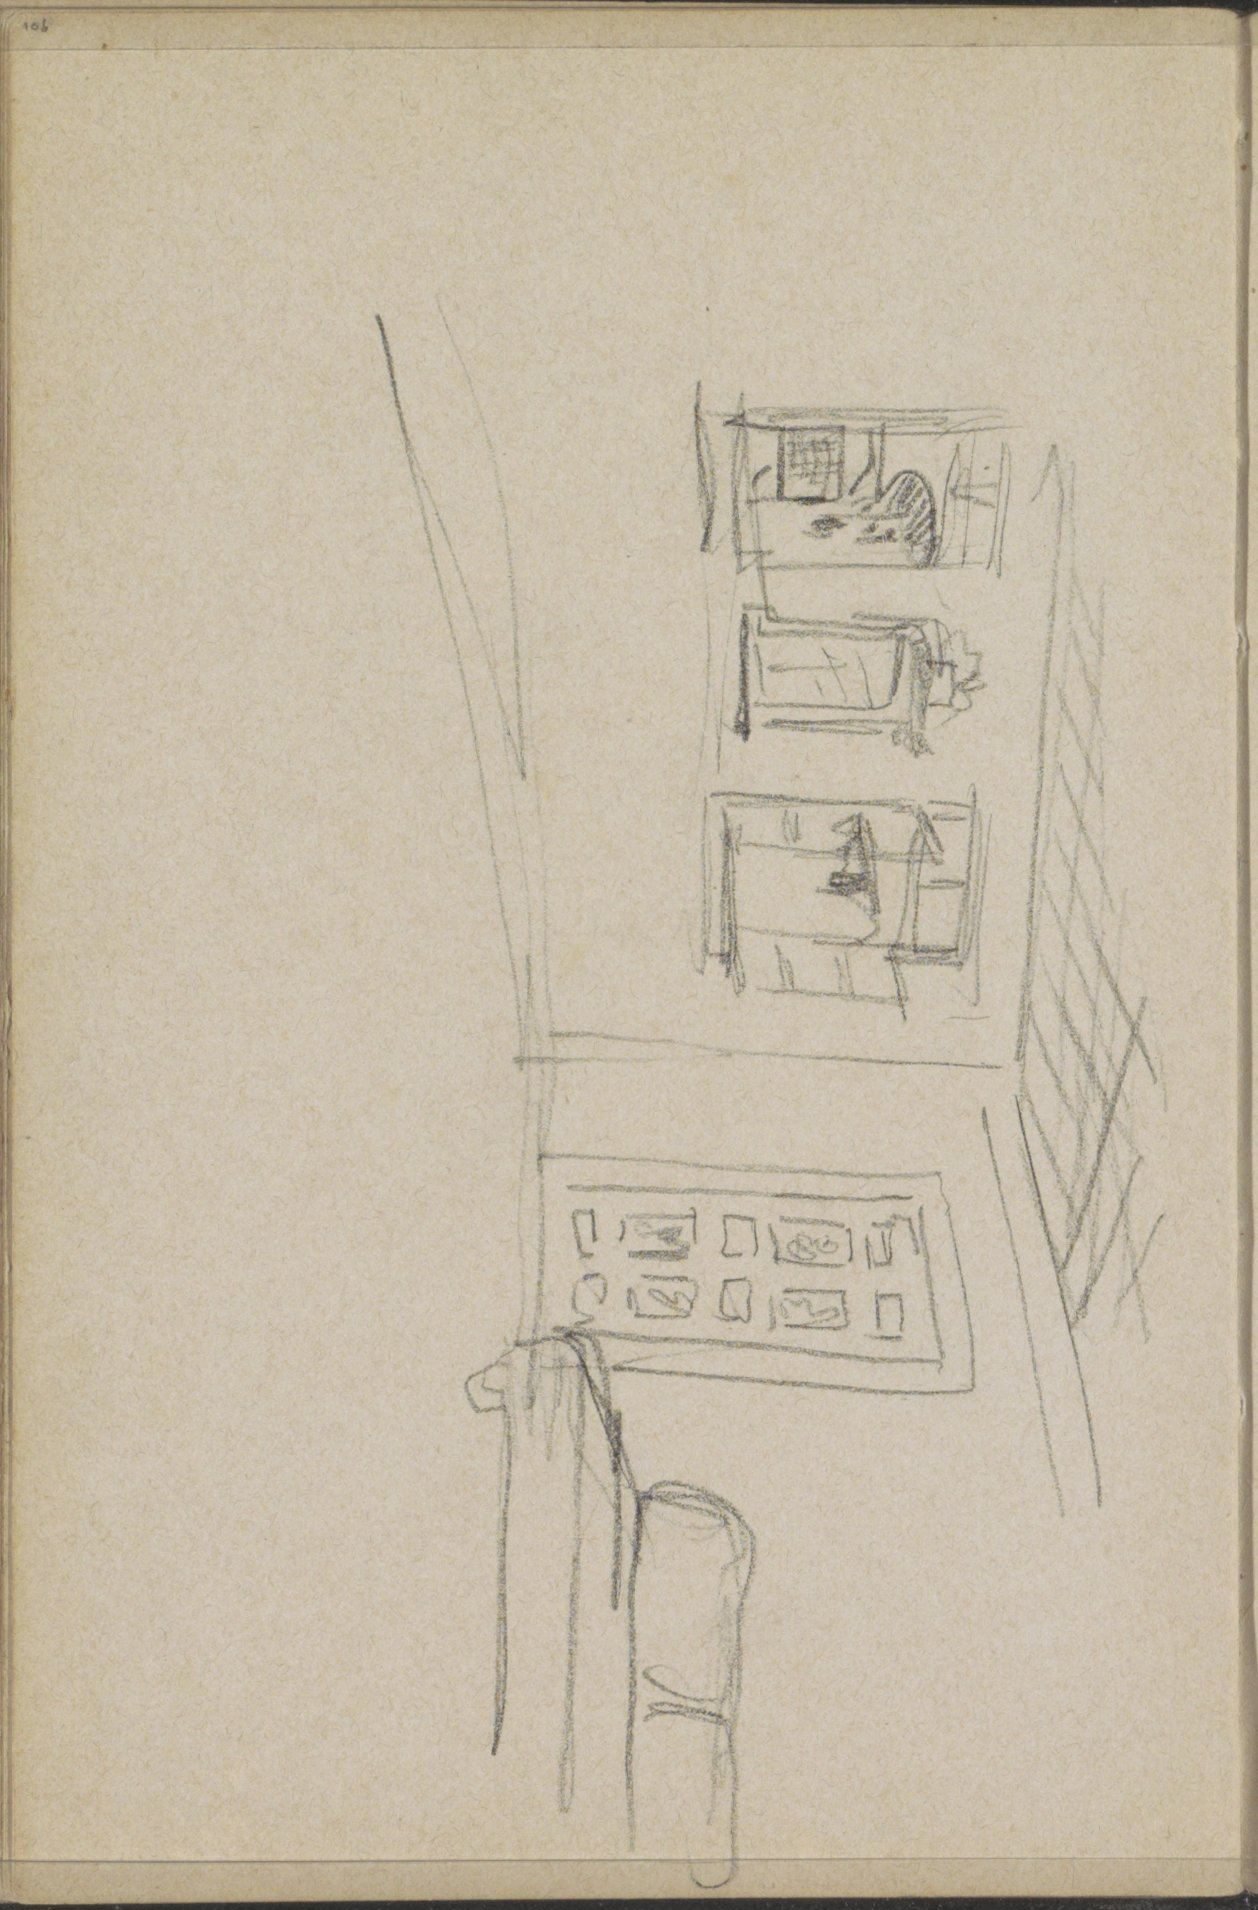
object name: sketchbook leaf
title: Interieur van het Bachi-Seraï Paleis op de Krim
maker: marius bauer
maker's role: draughtsman, print maker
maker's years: 1867-1932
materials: chalk, paper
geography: crimea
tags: palace, open window, interior ~ representation of a building, couch, sofa, settee, closed door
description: Pagina 106 uit een schetsboek met 54 bladen.